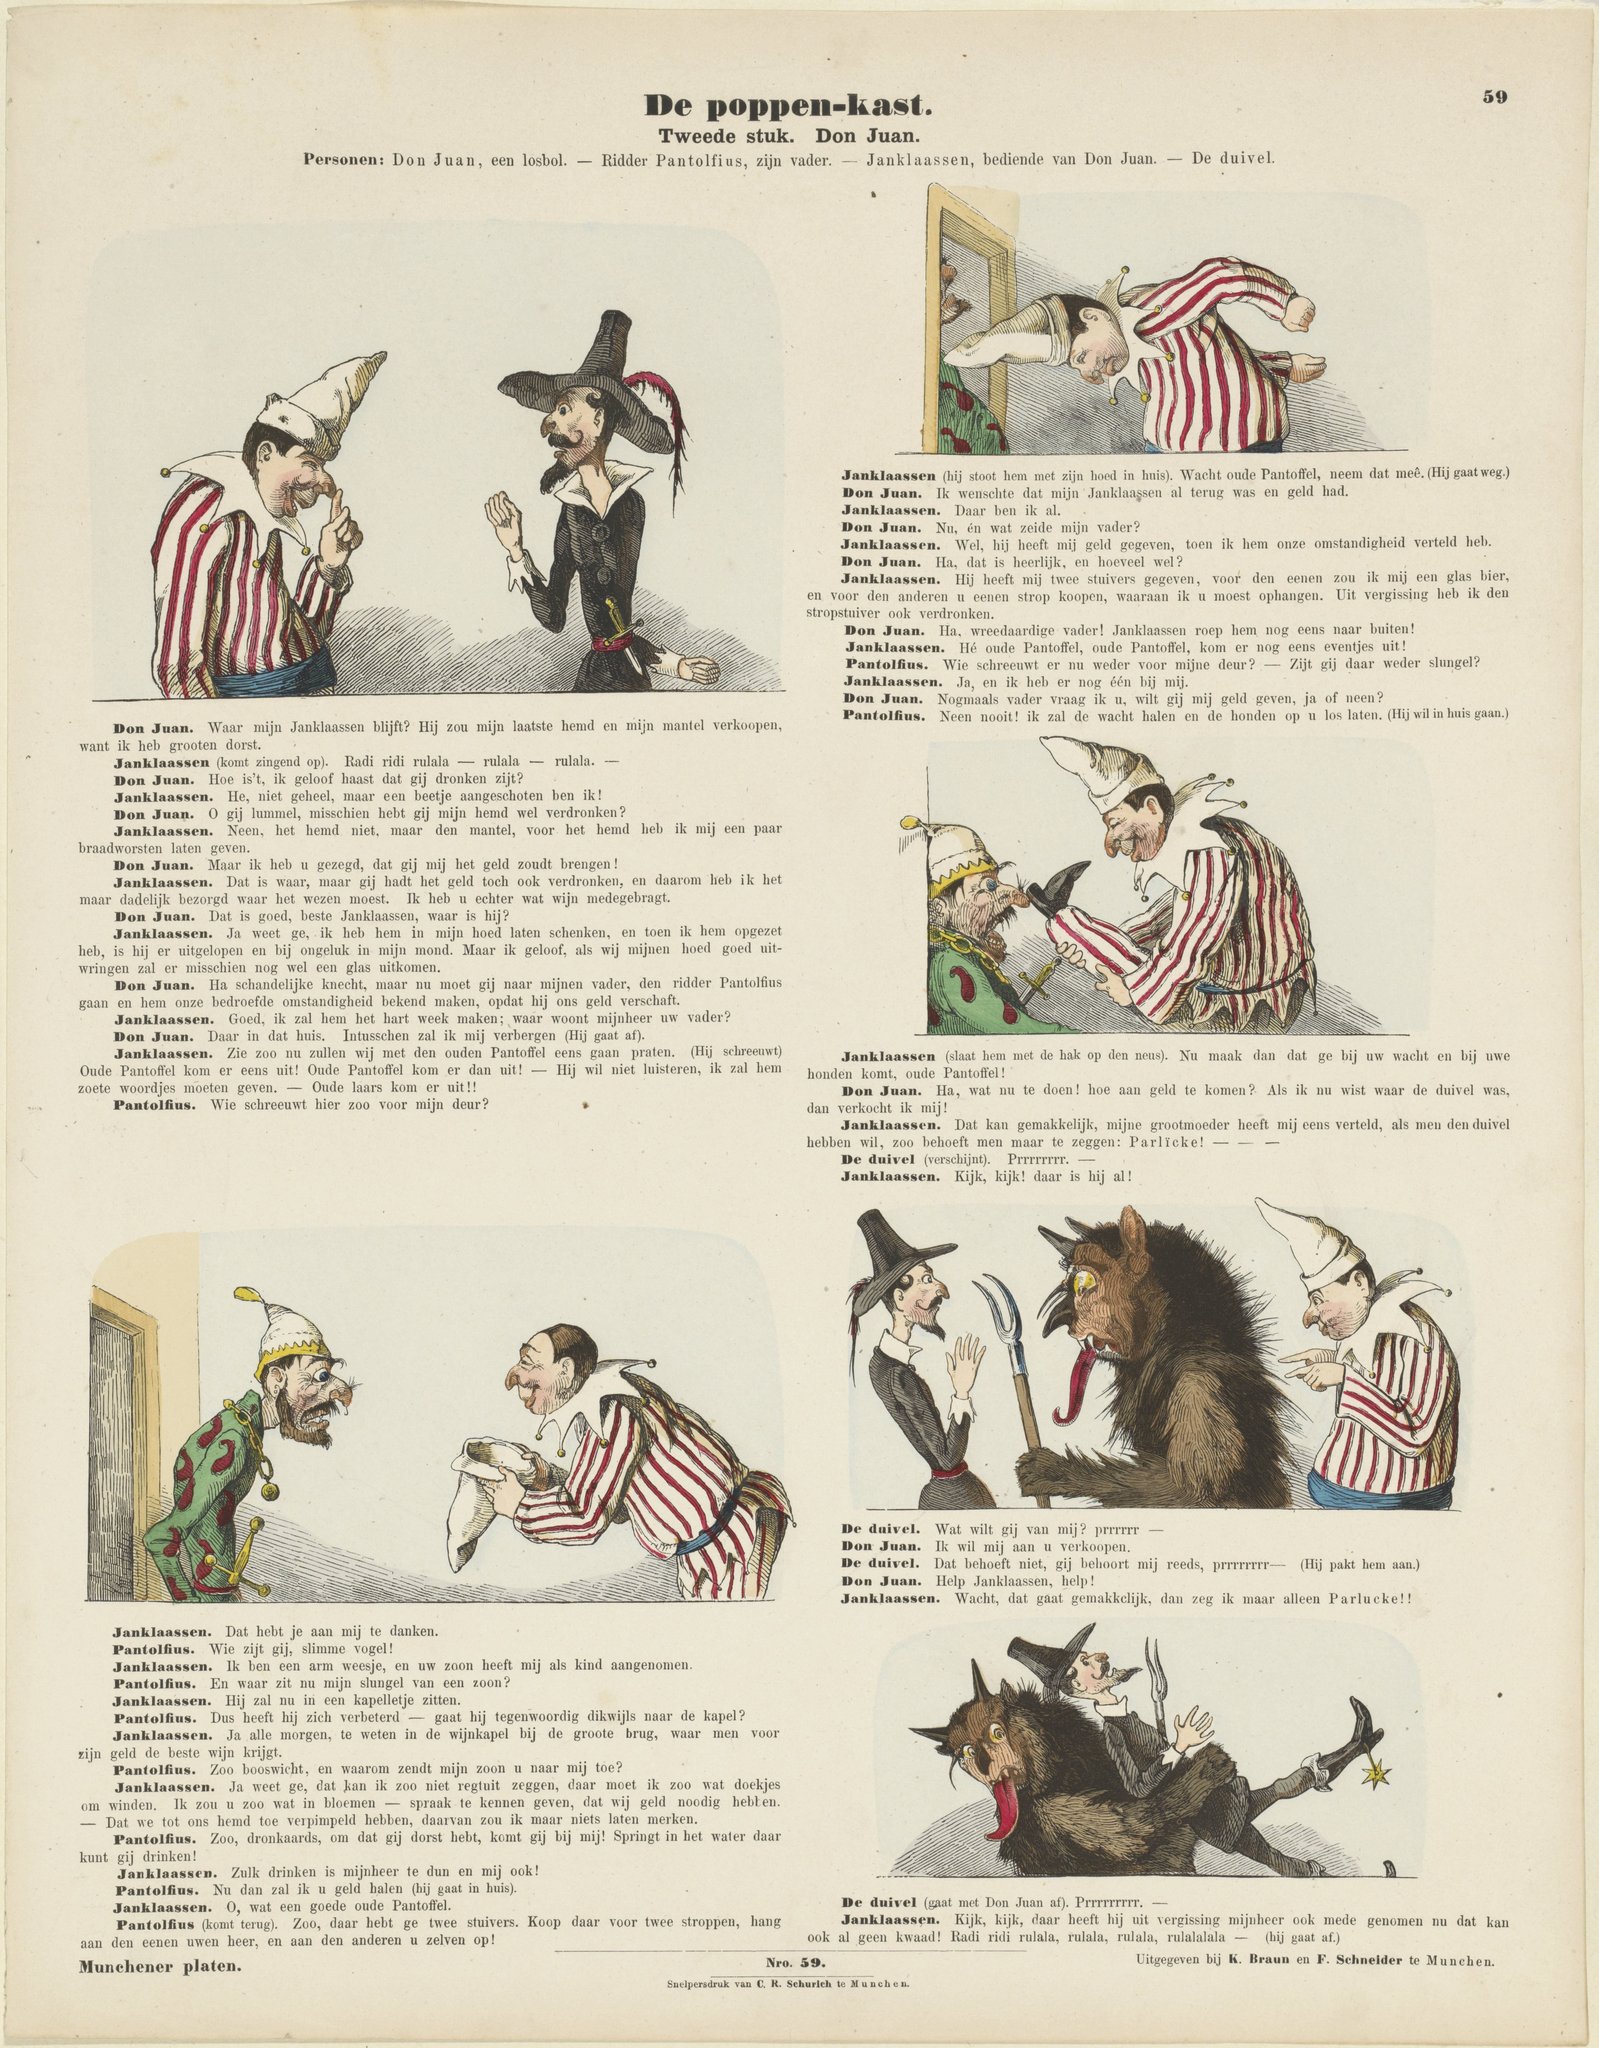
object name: print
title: De poppen-kast / Tweede stuk. Don Juan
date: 1843-1920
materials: paper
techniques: colour, letterpress printing, engraving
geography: germany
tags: puppet, punch and judy, don juan, puppet and marionette show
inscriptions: collector's mark: Lugt 2760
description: Blad met 6 voorstellingen van poppenkastpoppen. Onder de afbeeldingen tekst voor een poppenkastvoorstelling. Genummerd midden onder: Nro. 59. Genummerd rechtsboven: 59.